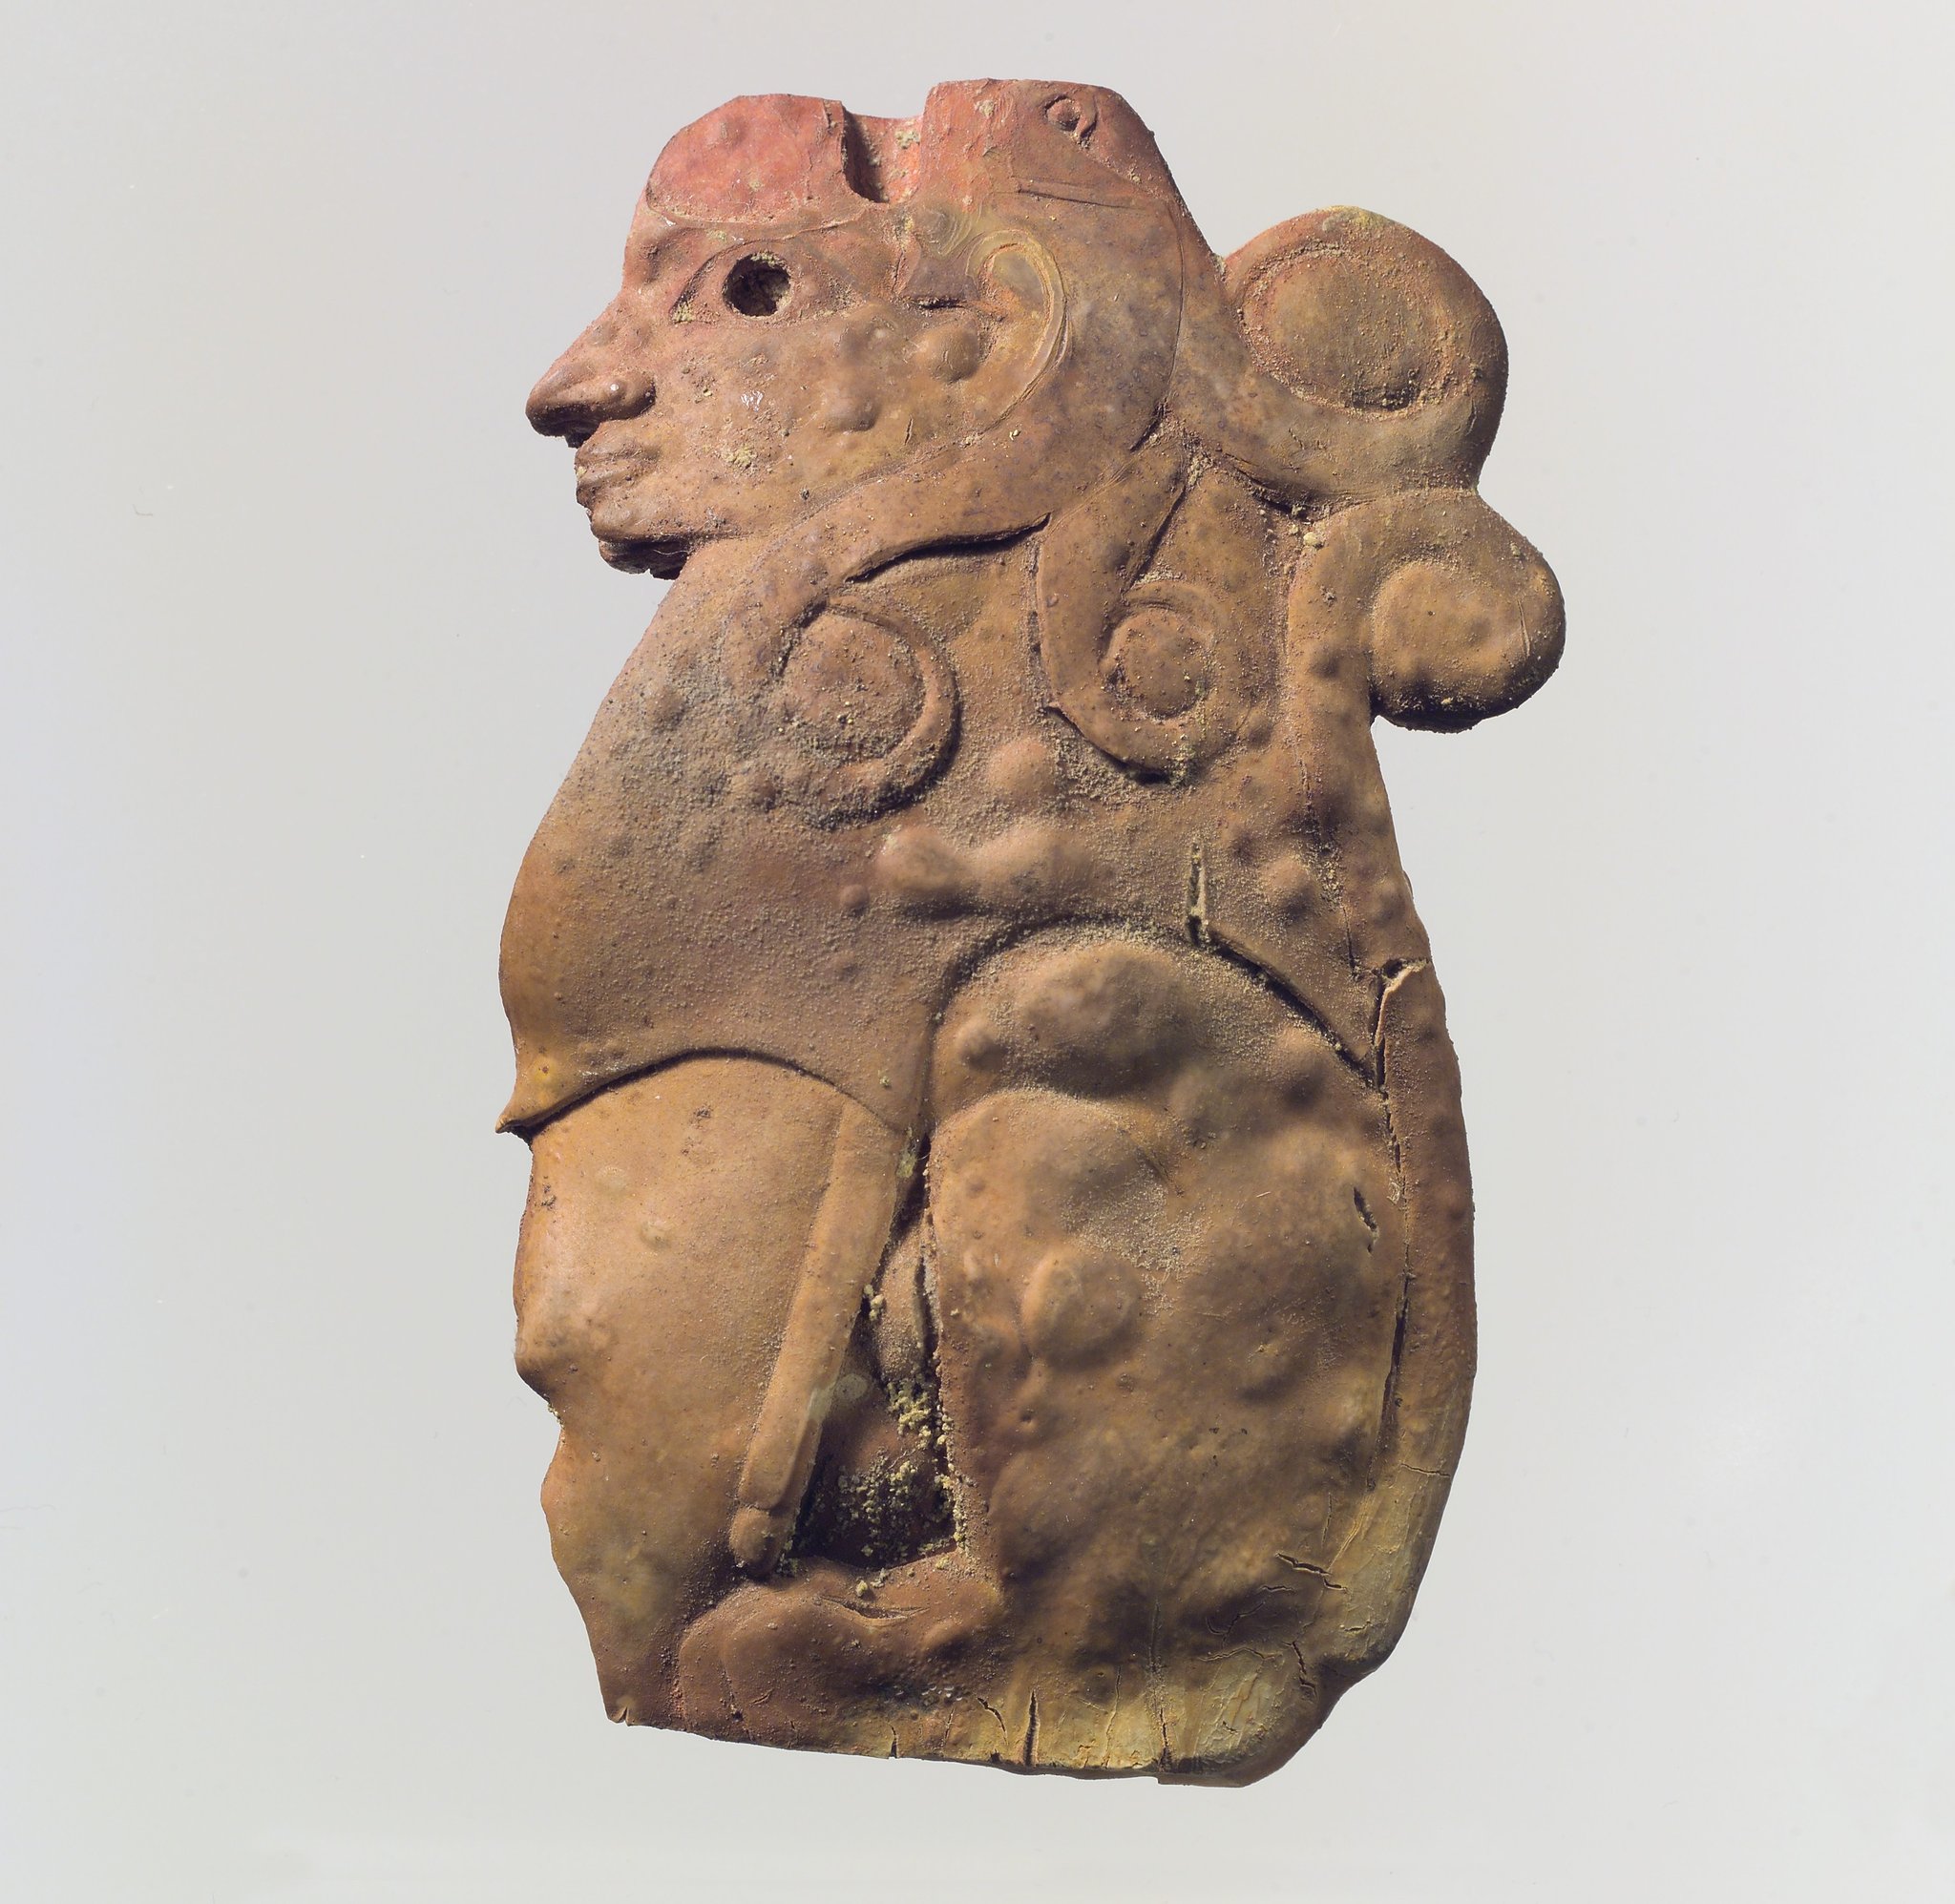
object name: furniture element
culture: assyrian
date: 1800-1701 BCE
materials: ivory, paint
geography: anatolia